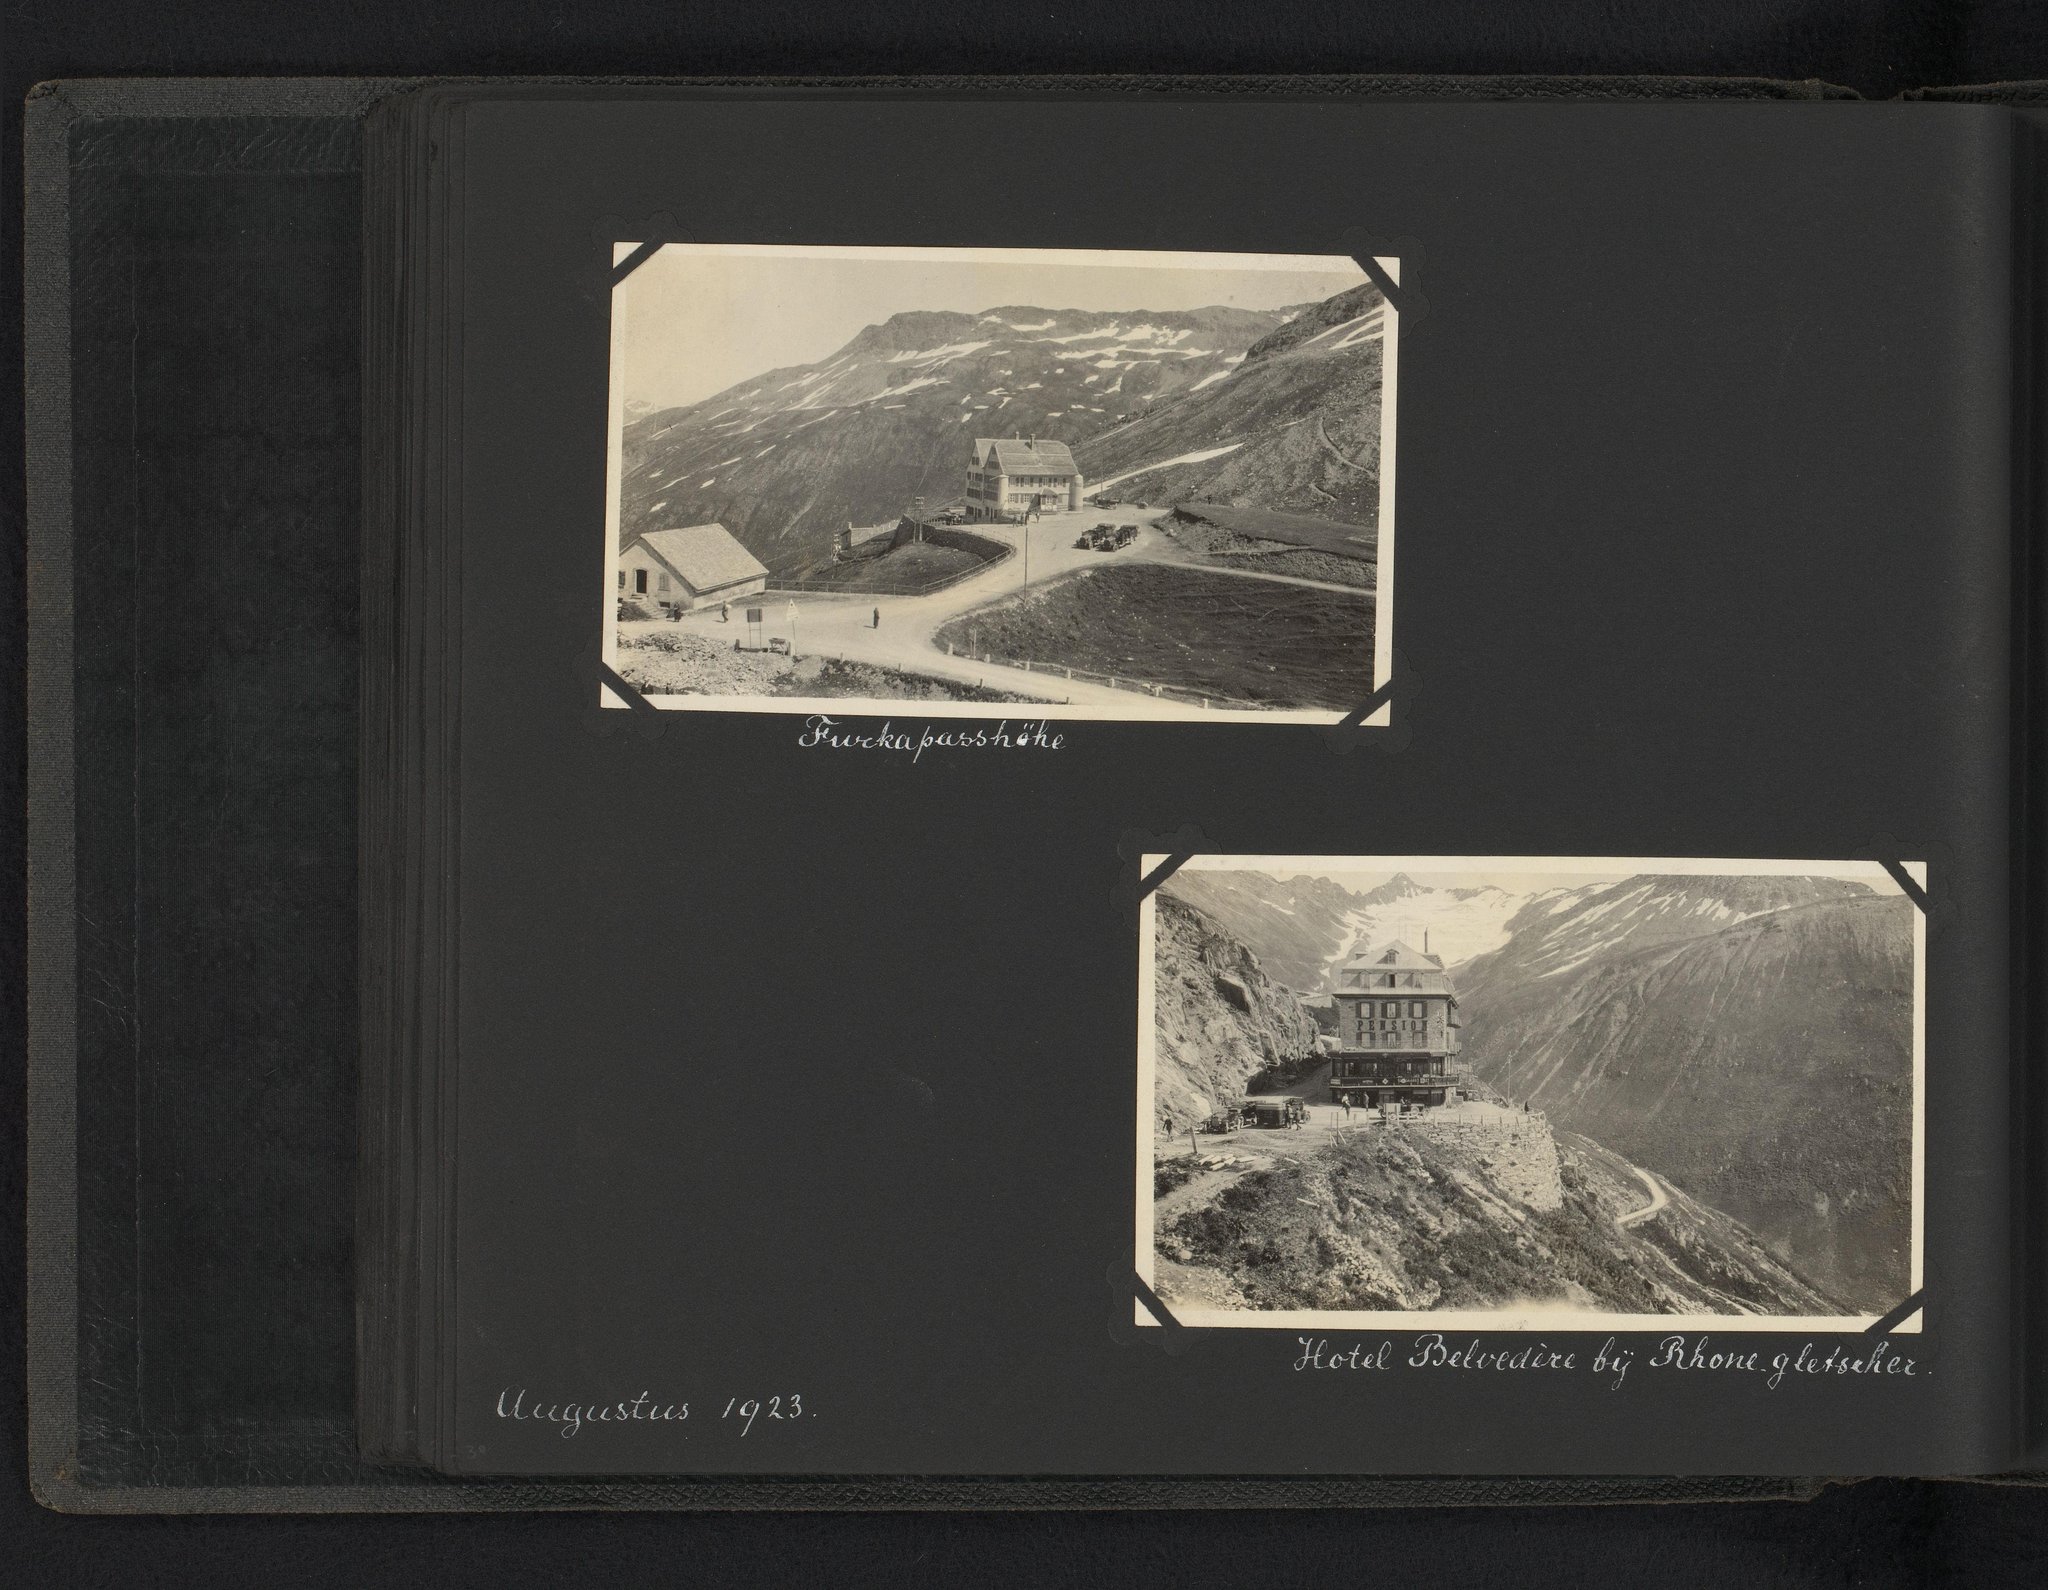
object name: photograph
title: Augustus 1923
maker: hendrik herman van den berg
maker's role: amateurfotograaf, jurist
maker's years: 1875-1944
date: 1908-1923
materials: paper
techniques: gelatin silver print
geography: furkapas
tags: hotel, hostelry, inn, mountains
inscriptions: inscription: ‘Furkapasshöhe’, inscription: ‘Hotel Belvedère bij Rhone-gletscher’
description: Deze foto's maken deel uit van een album.